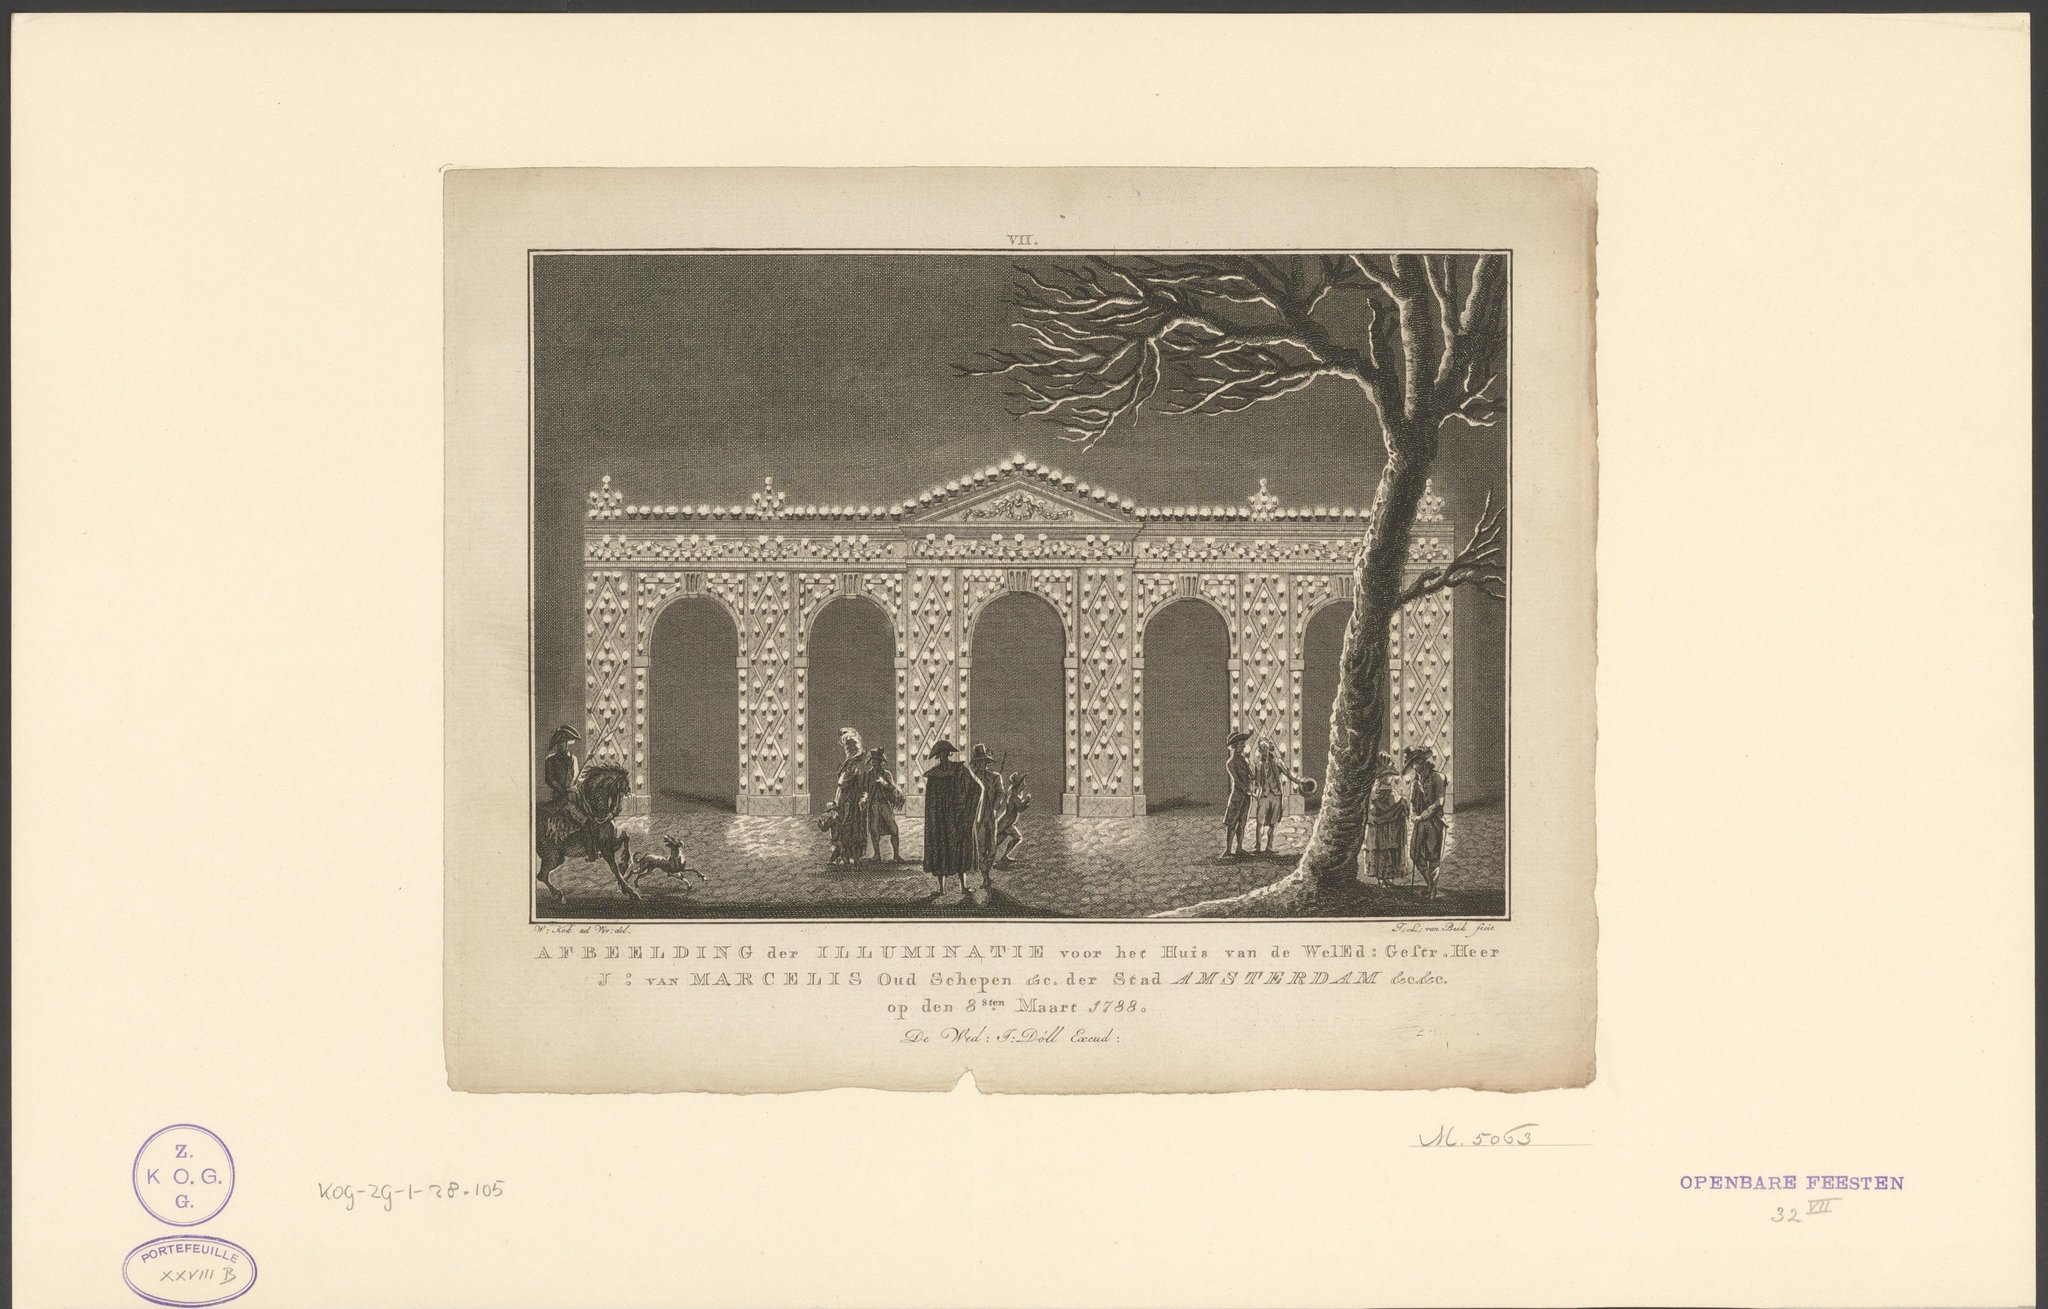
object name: print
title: Illuminatiën en decoratiën te Amsterdam op de 40ste verjaardag van prins Willem V in 1788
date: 1788-1790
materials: paper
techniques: engraving, etching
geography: amsterdam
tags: the hague, william v (prince of orange), bonfire, fire-works (+ illumination, fire-works ~ festive activities), amsterdam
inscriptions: stamp, collector's mark: Lugt 1641, stamp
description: Illuminatie aangebracht voor het huis van Jan van Marcelis aan de Herengracht te Amsterdam. Genummerd bovenaan: VII. Onderdeel van een reeks van twaalf platen van de illuminaties en decoraties te Amsterdam op de 40ste verjaardag van prins Willem V op 8 maart 1788. Onderwerpsrubrieken binnen de Atlas Zeden en Gewoonten: Zeden en Gewoonten in Engeren Zin. Volksleven. Openbare feesten. Vorstelijke intochten, (Illuminaties, vuurwerken en dergelijke, openbare feesten).